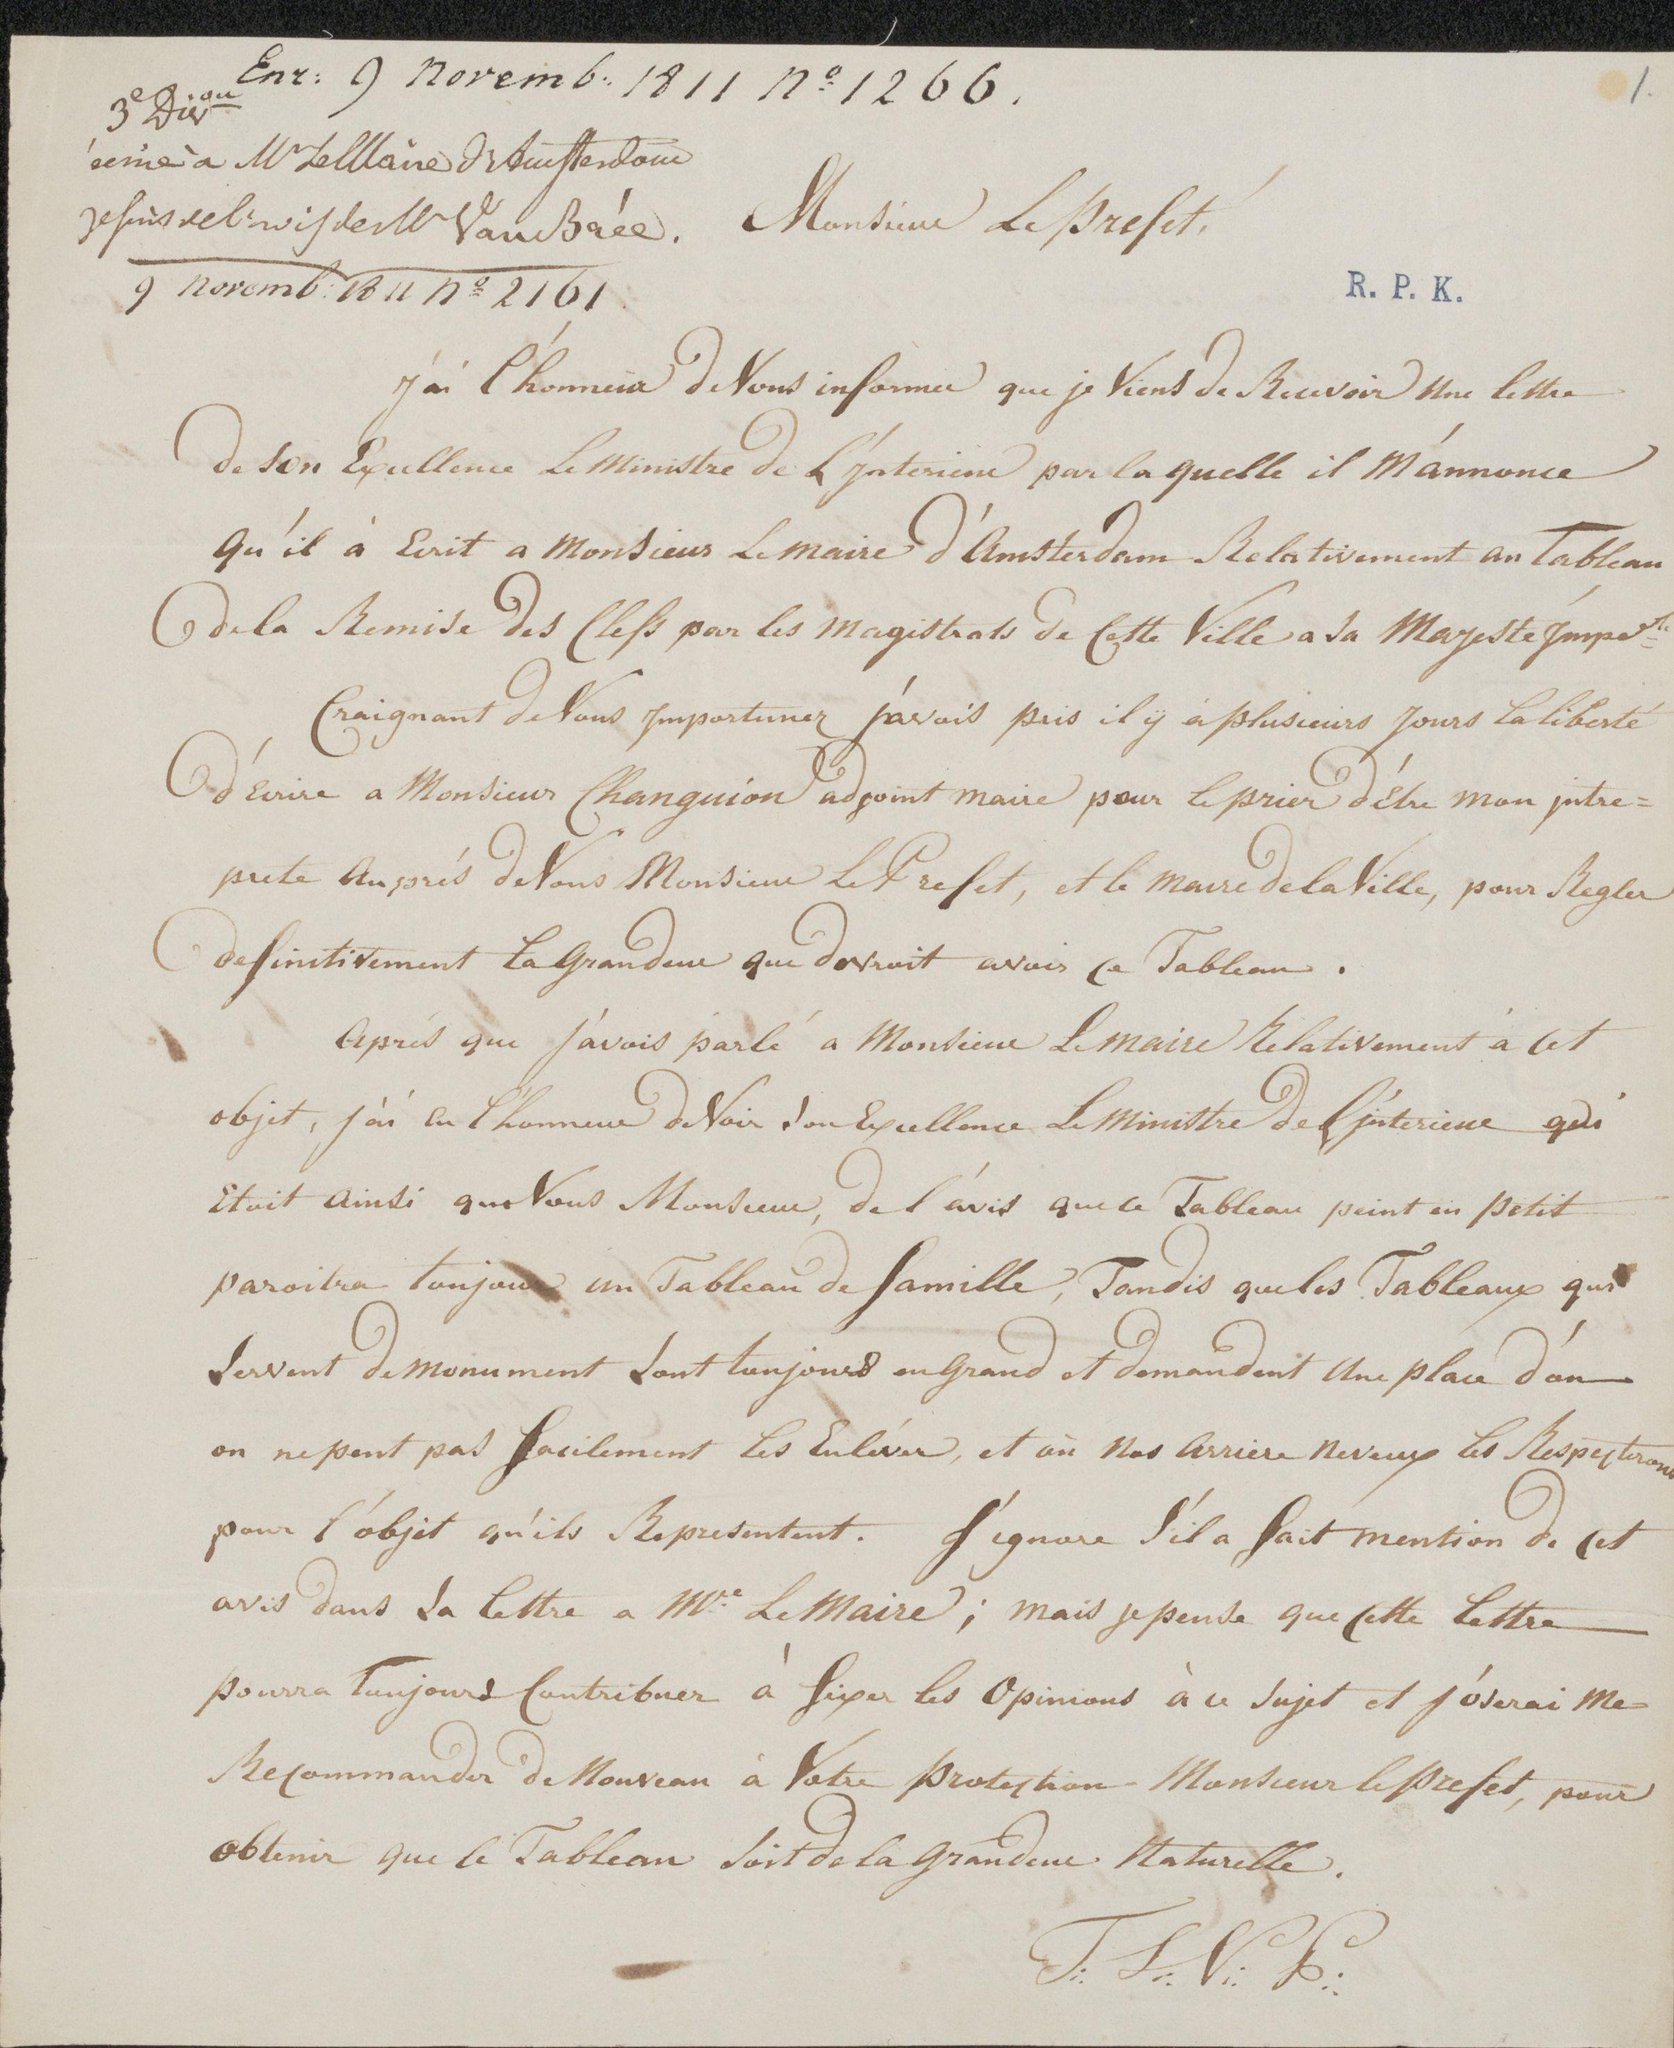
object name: letter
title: Brief aan Antoine de Celles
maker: mattheus ignatius van bree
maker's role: draughtsman, print maker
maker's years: 1773-1839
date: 1811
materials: ink, paper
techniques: pen, writing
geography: antwerp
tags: painting (including book-illumination, miniature-painting), amsterdam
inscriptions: collector's mark: Lugt 2233